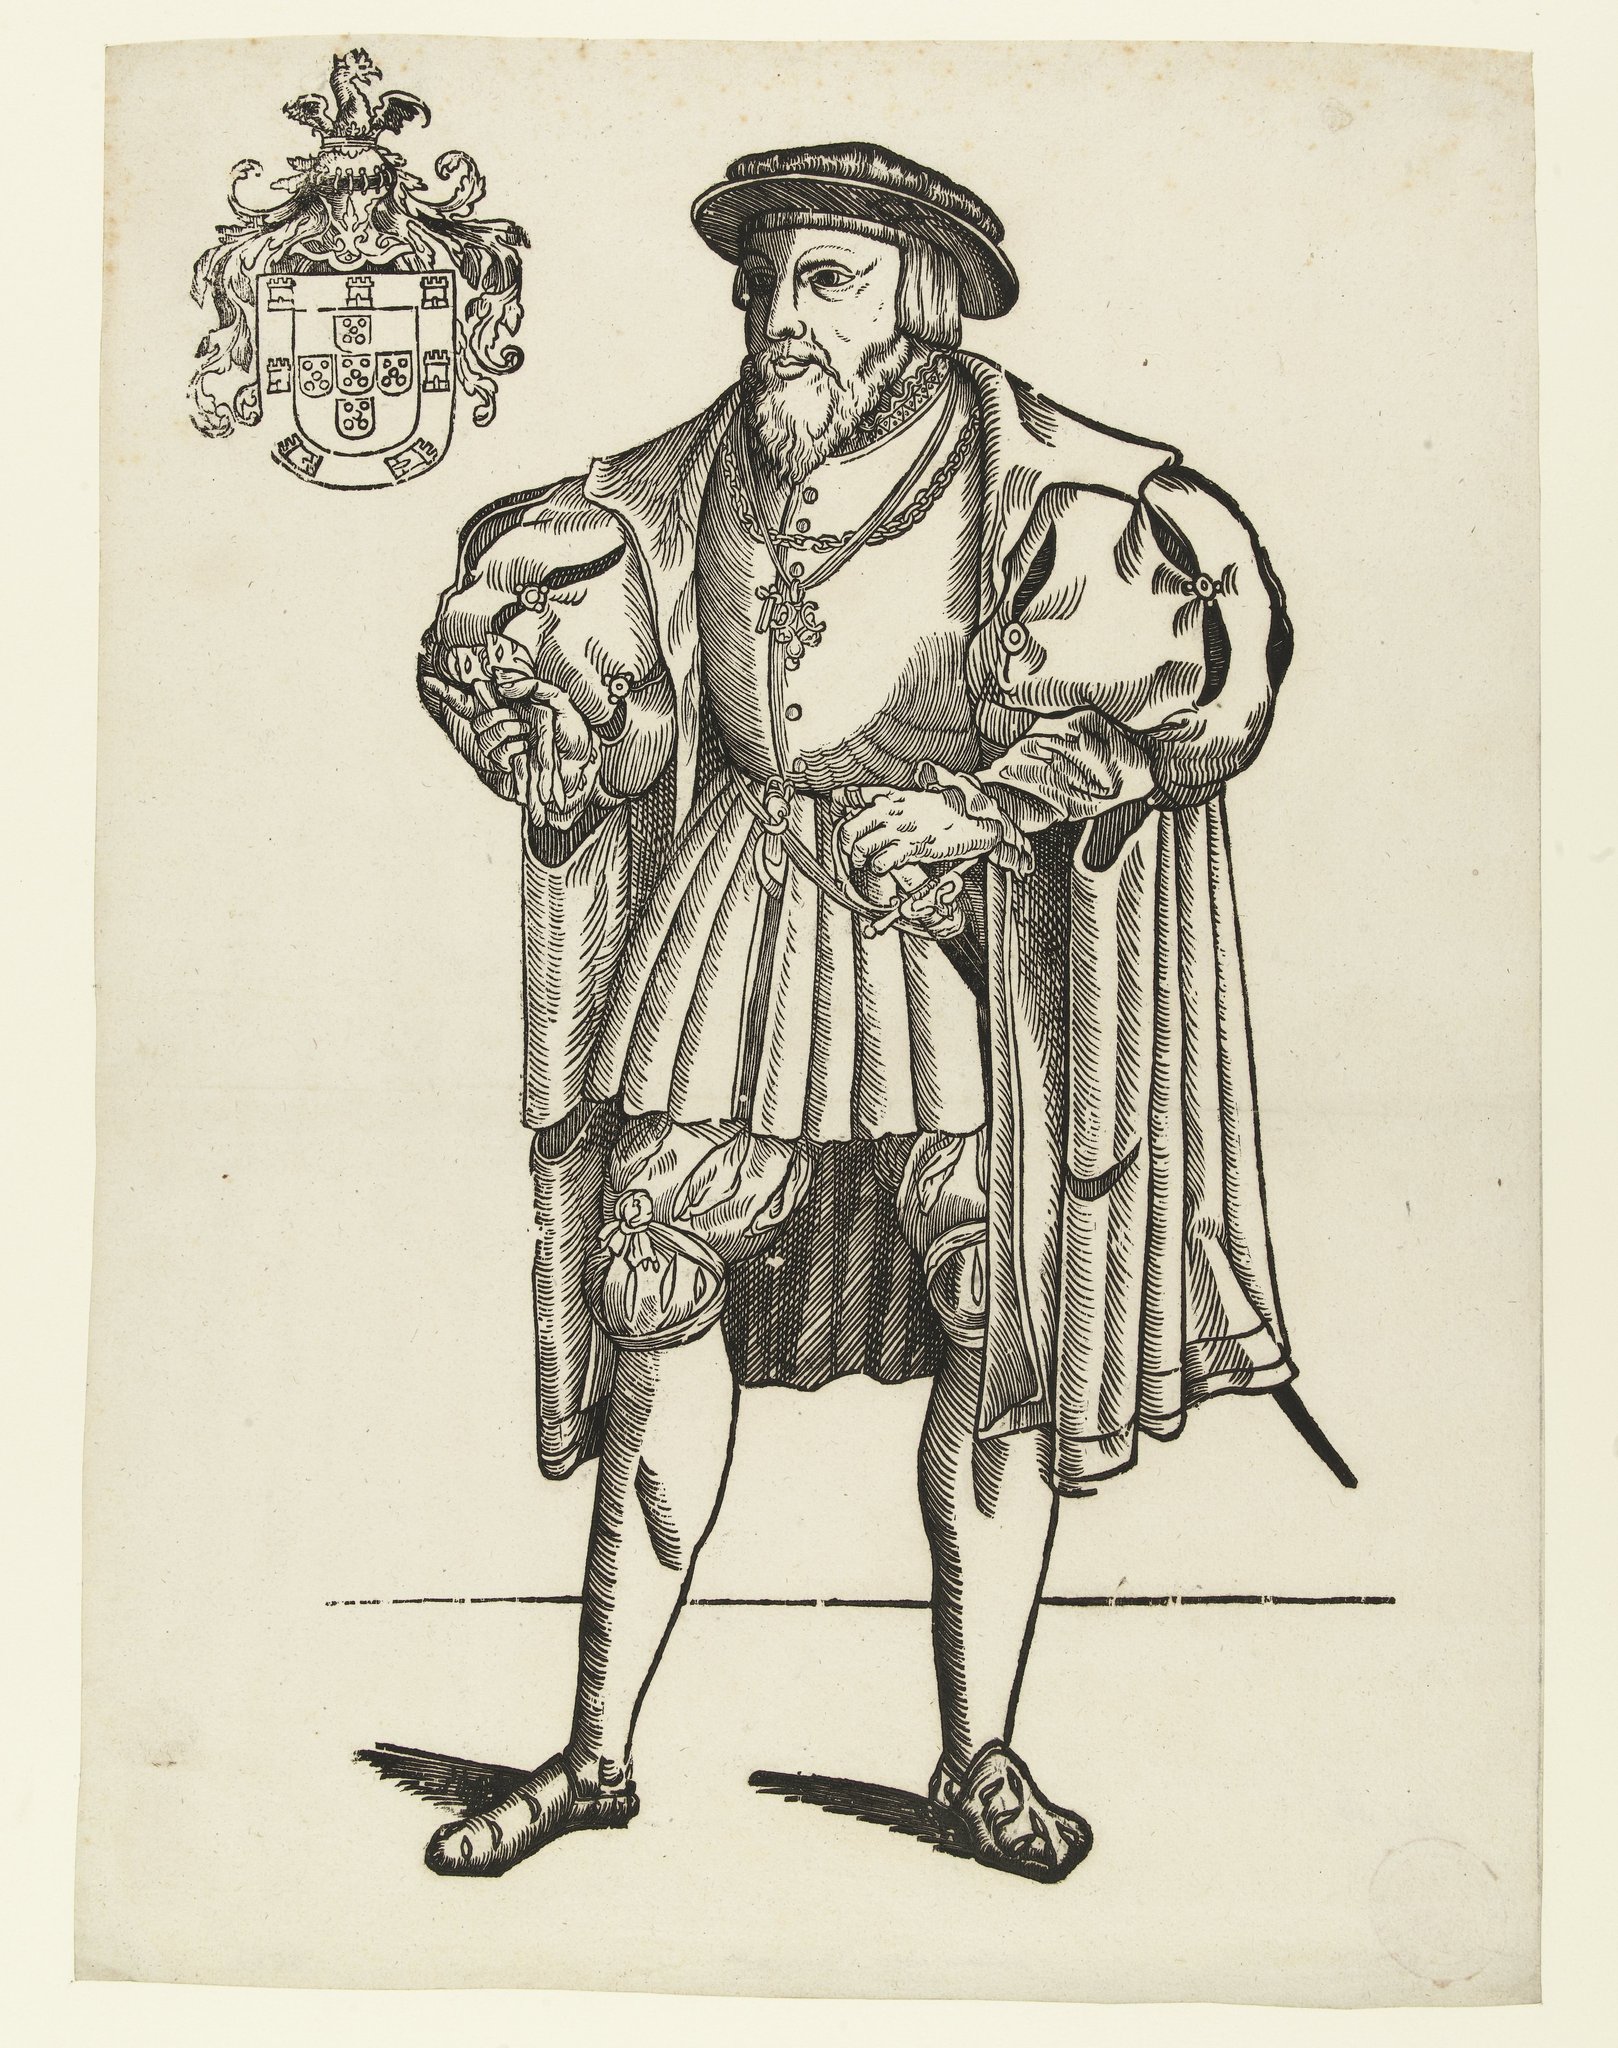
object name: print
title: Portret van Johannes III van Portugal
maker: Anonymous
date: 1550-1557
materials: paper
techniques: woodcut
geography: low countries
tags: johannes iii (koning van portugal)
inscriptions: collector's mark: Lugt 240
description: Portret van Johannes III van Portugal ten voeten uit, in de rechterhand de handschoenen. Linkerhand op het gevest van zijn zwaard. Linksboven zijn wapen.